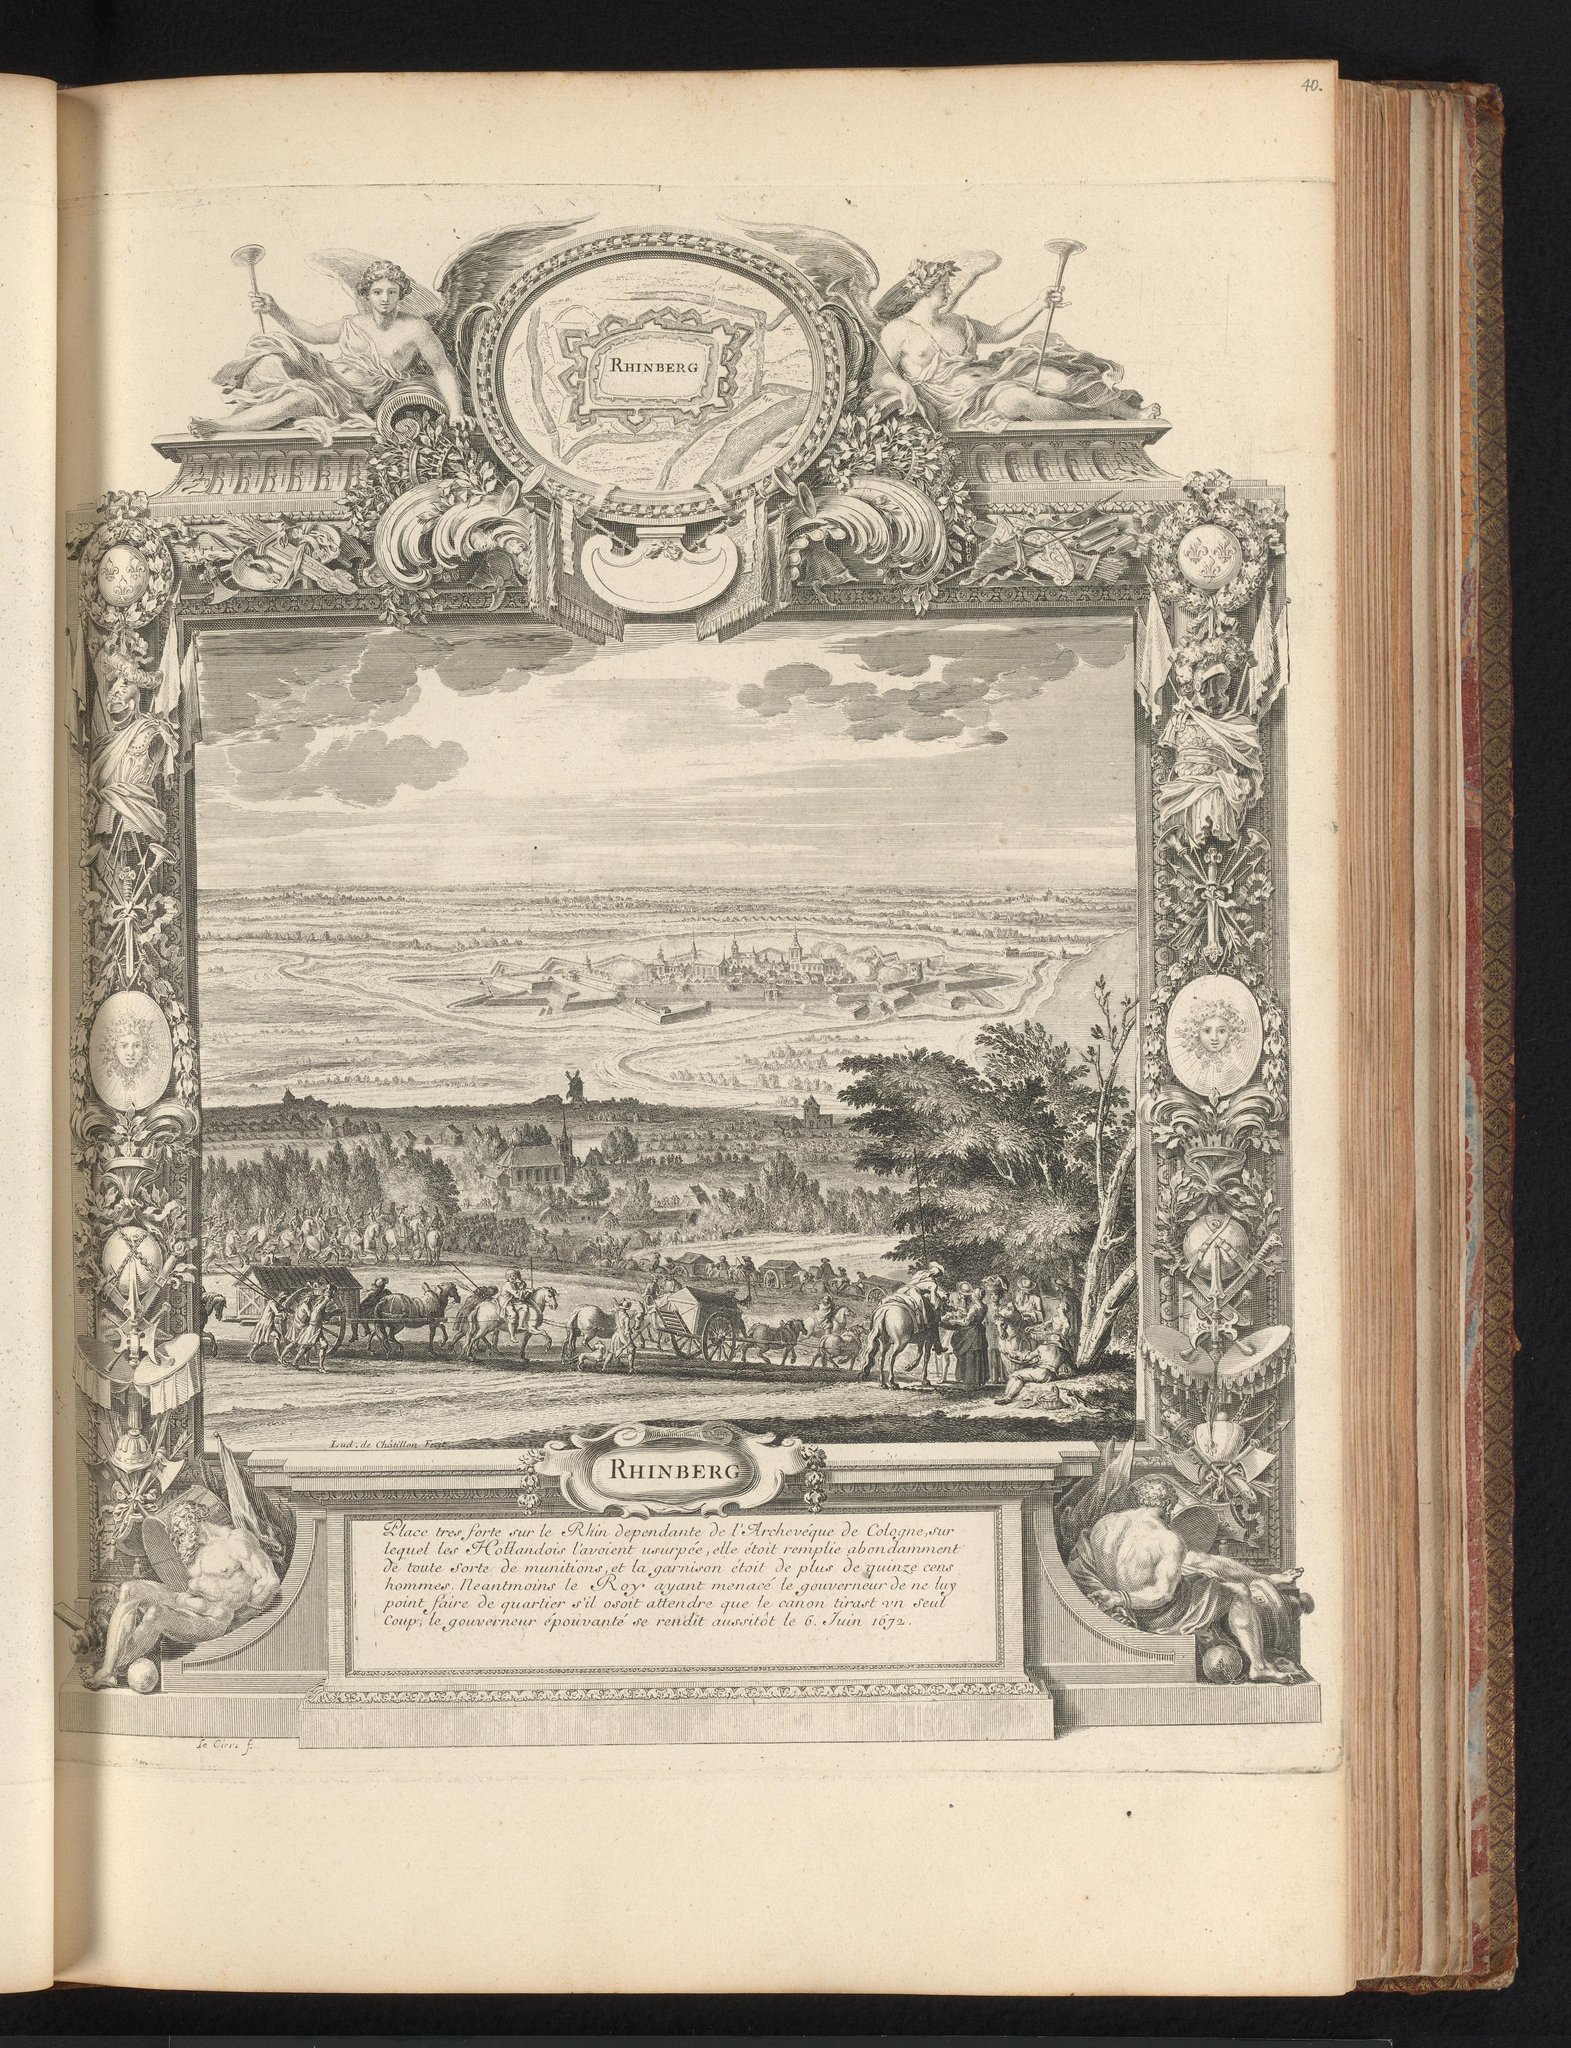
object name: album leaf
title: Grote overwinningen van koning Lodewijk XIV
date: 1686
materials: paper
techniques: engraving, etching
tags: siege, position war, battle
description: Maakt deel uit van een serie bestaande uit 28 prenten met oorlogstaferelen in ornamentele cartouches. De prenten zijn gedrukt van twee afzonderlijke platen bestaande uit de voorstelling en de cartouche.